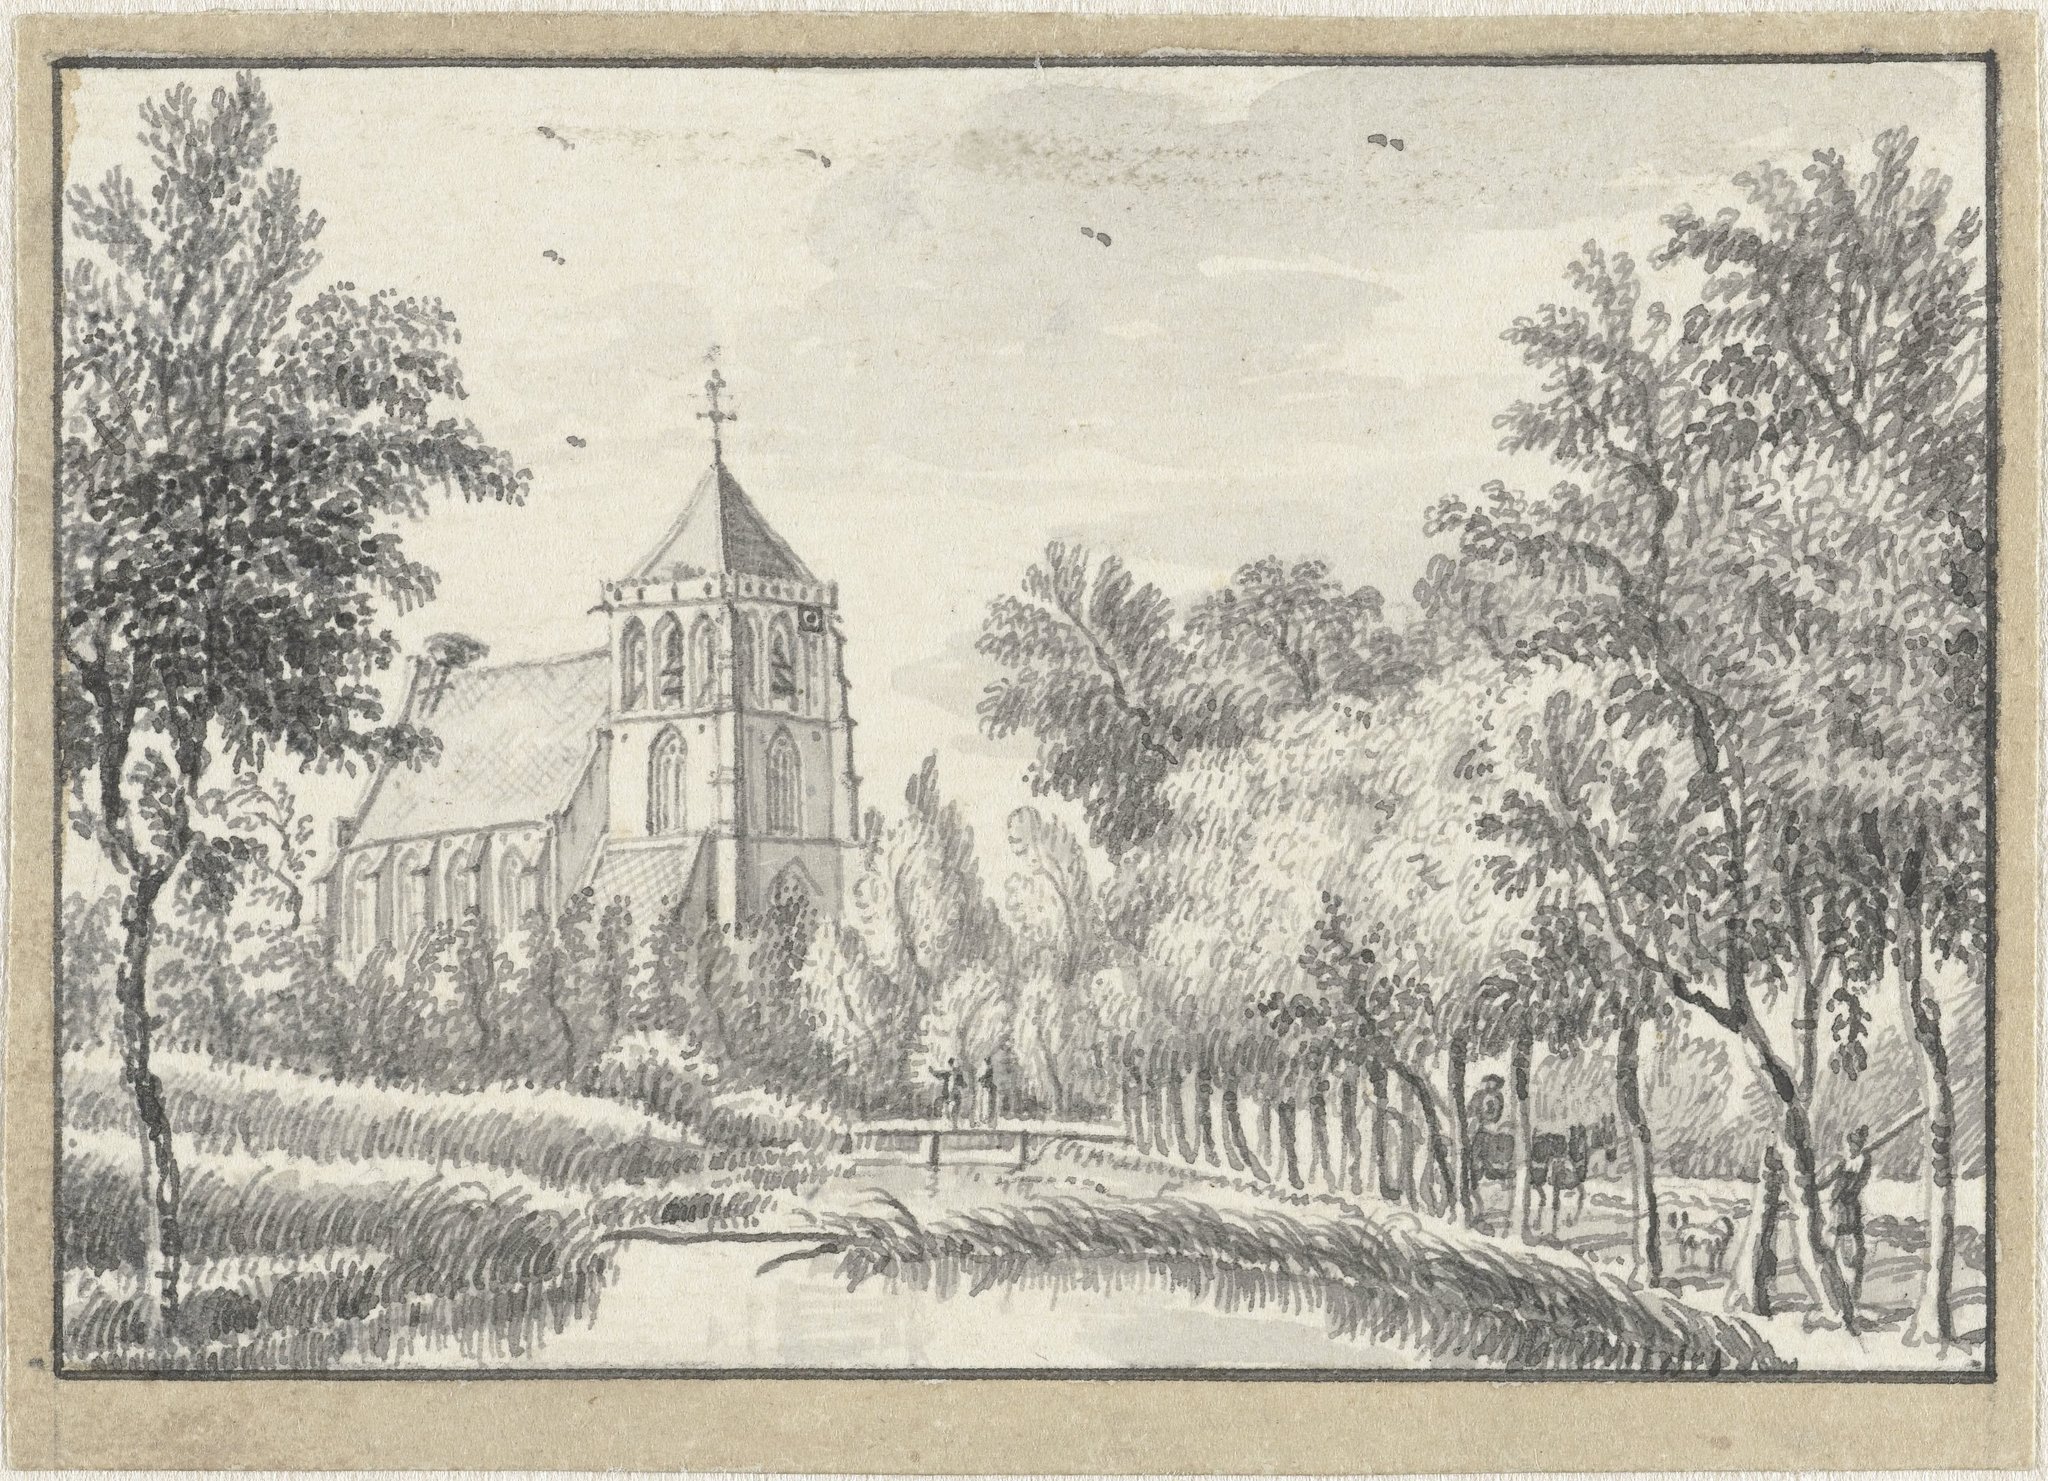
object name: drawing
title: Gezicht op de kerk van Leerbroek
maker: jan de beijer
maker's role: draughtsman, print maker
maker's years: 1703-1780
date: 1713-1780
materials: ink, paper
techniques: brush, pen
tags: church (exterior)